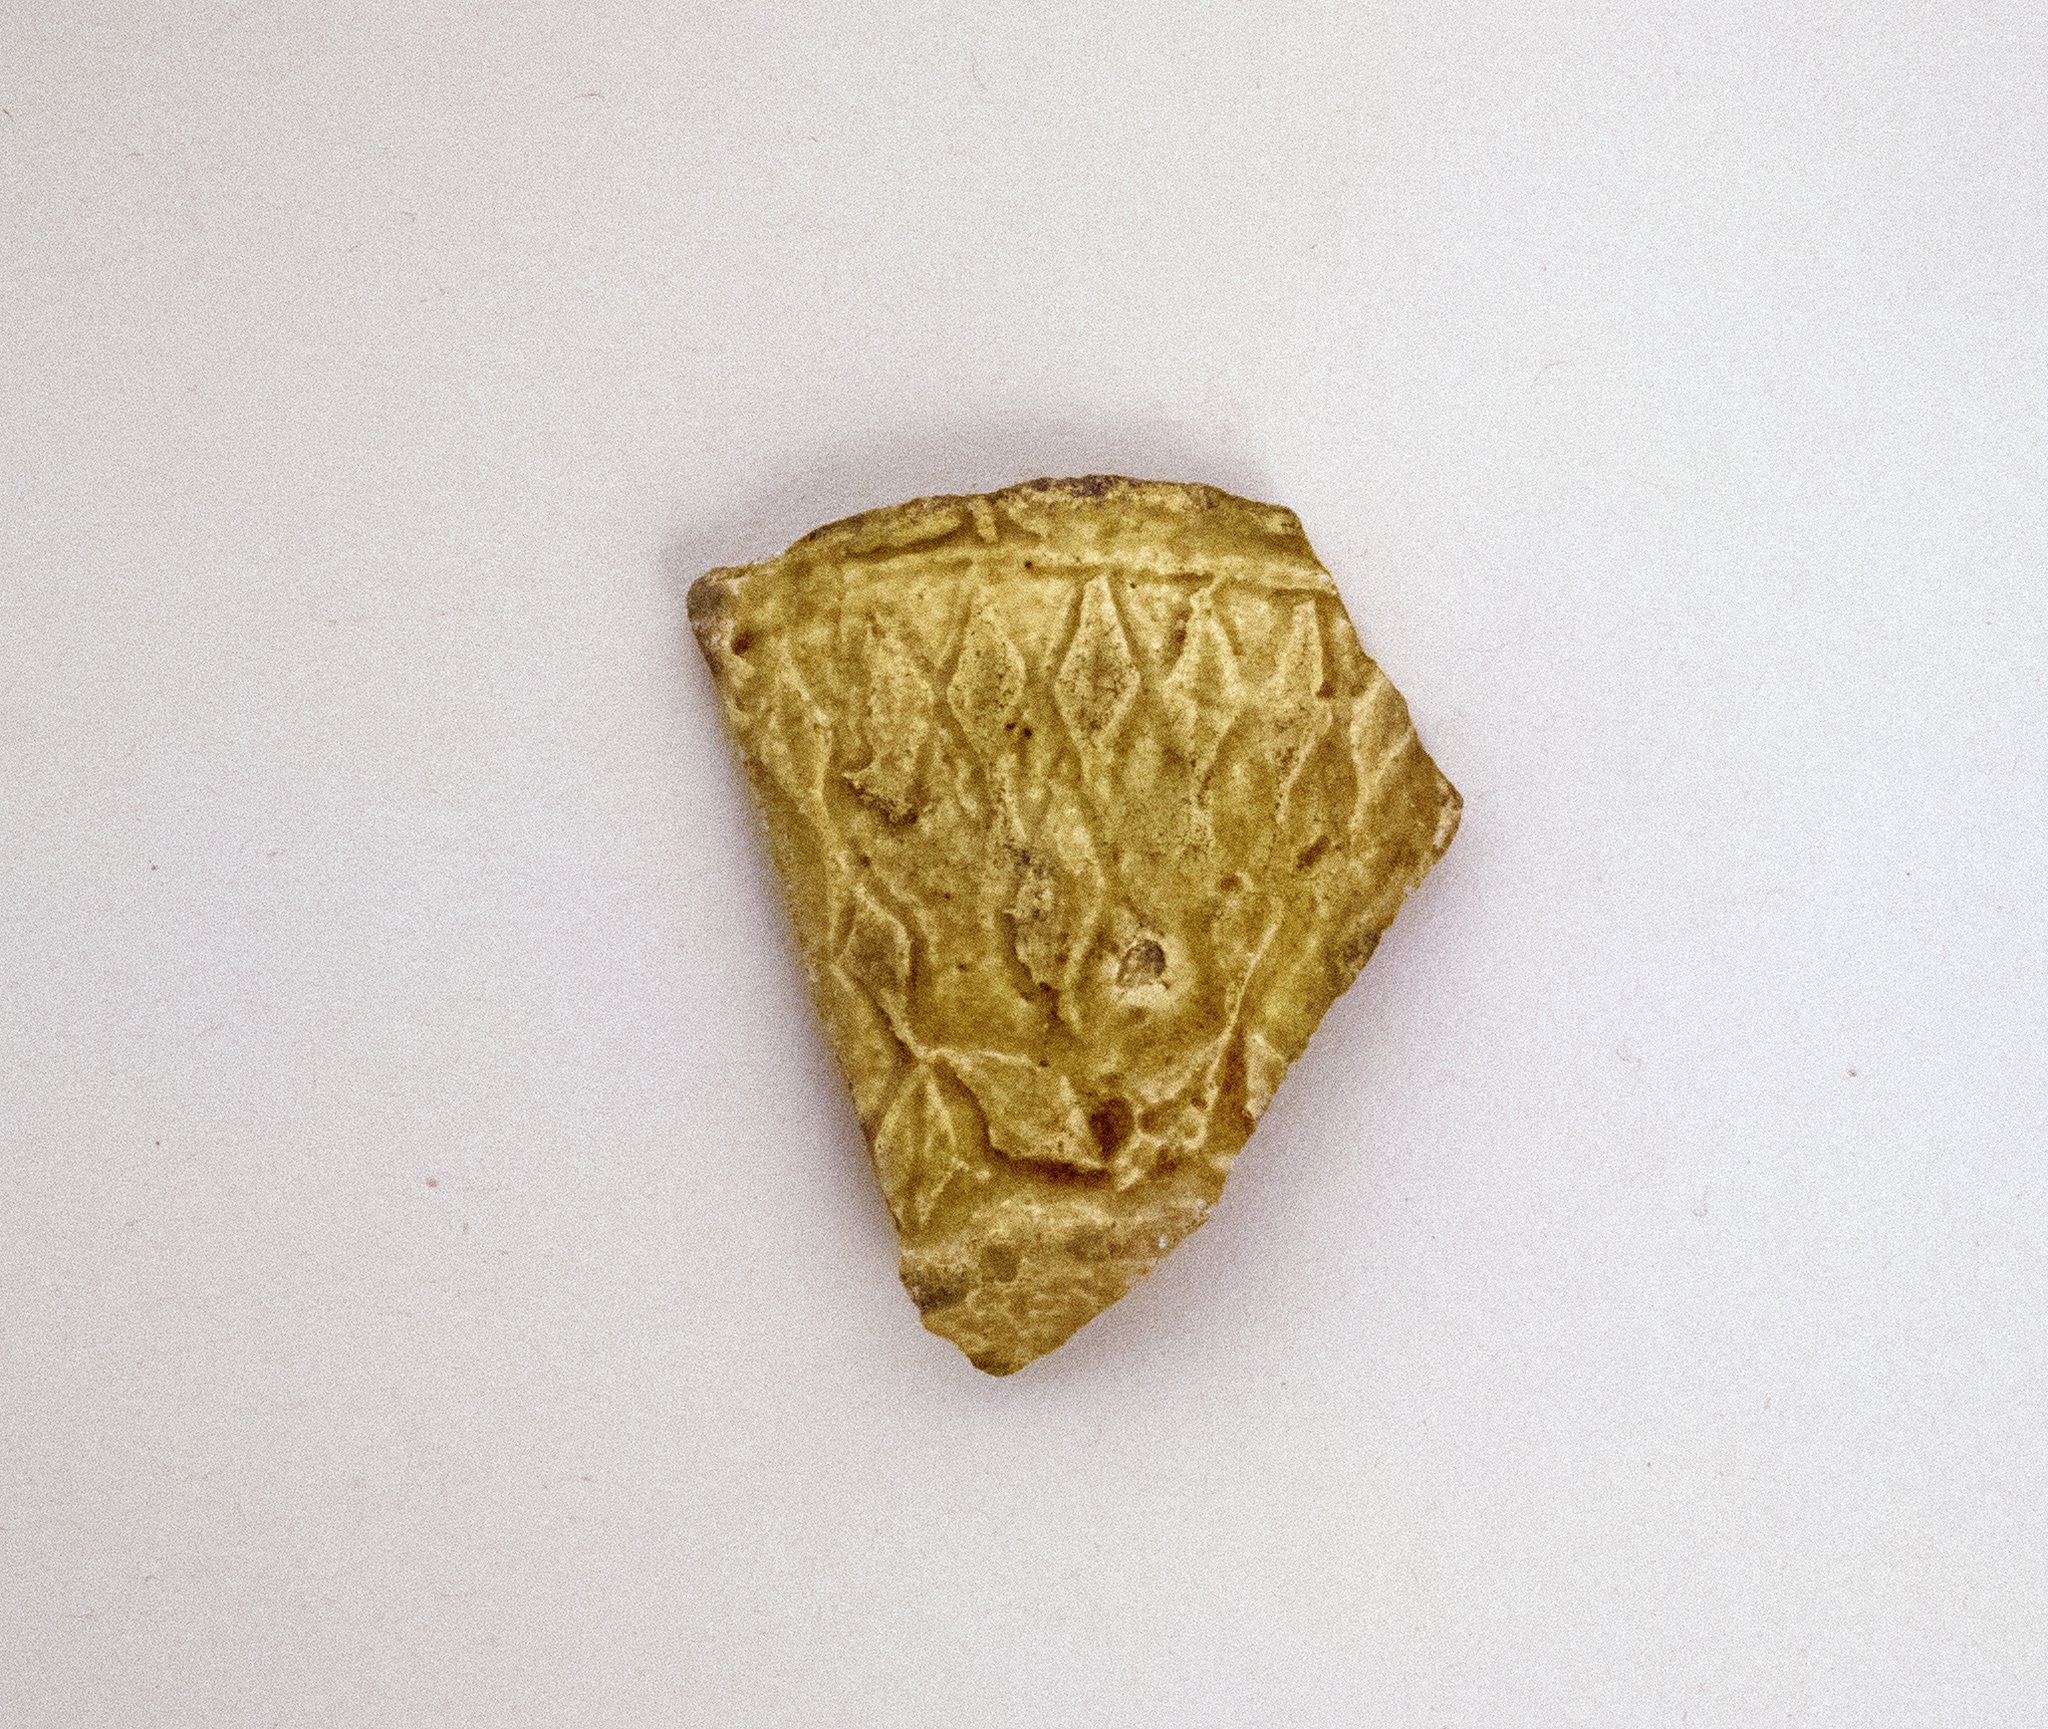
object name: vase fragment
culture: roman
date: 670 BCE-330 CE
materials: terracotta